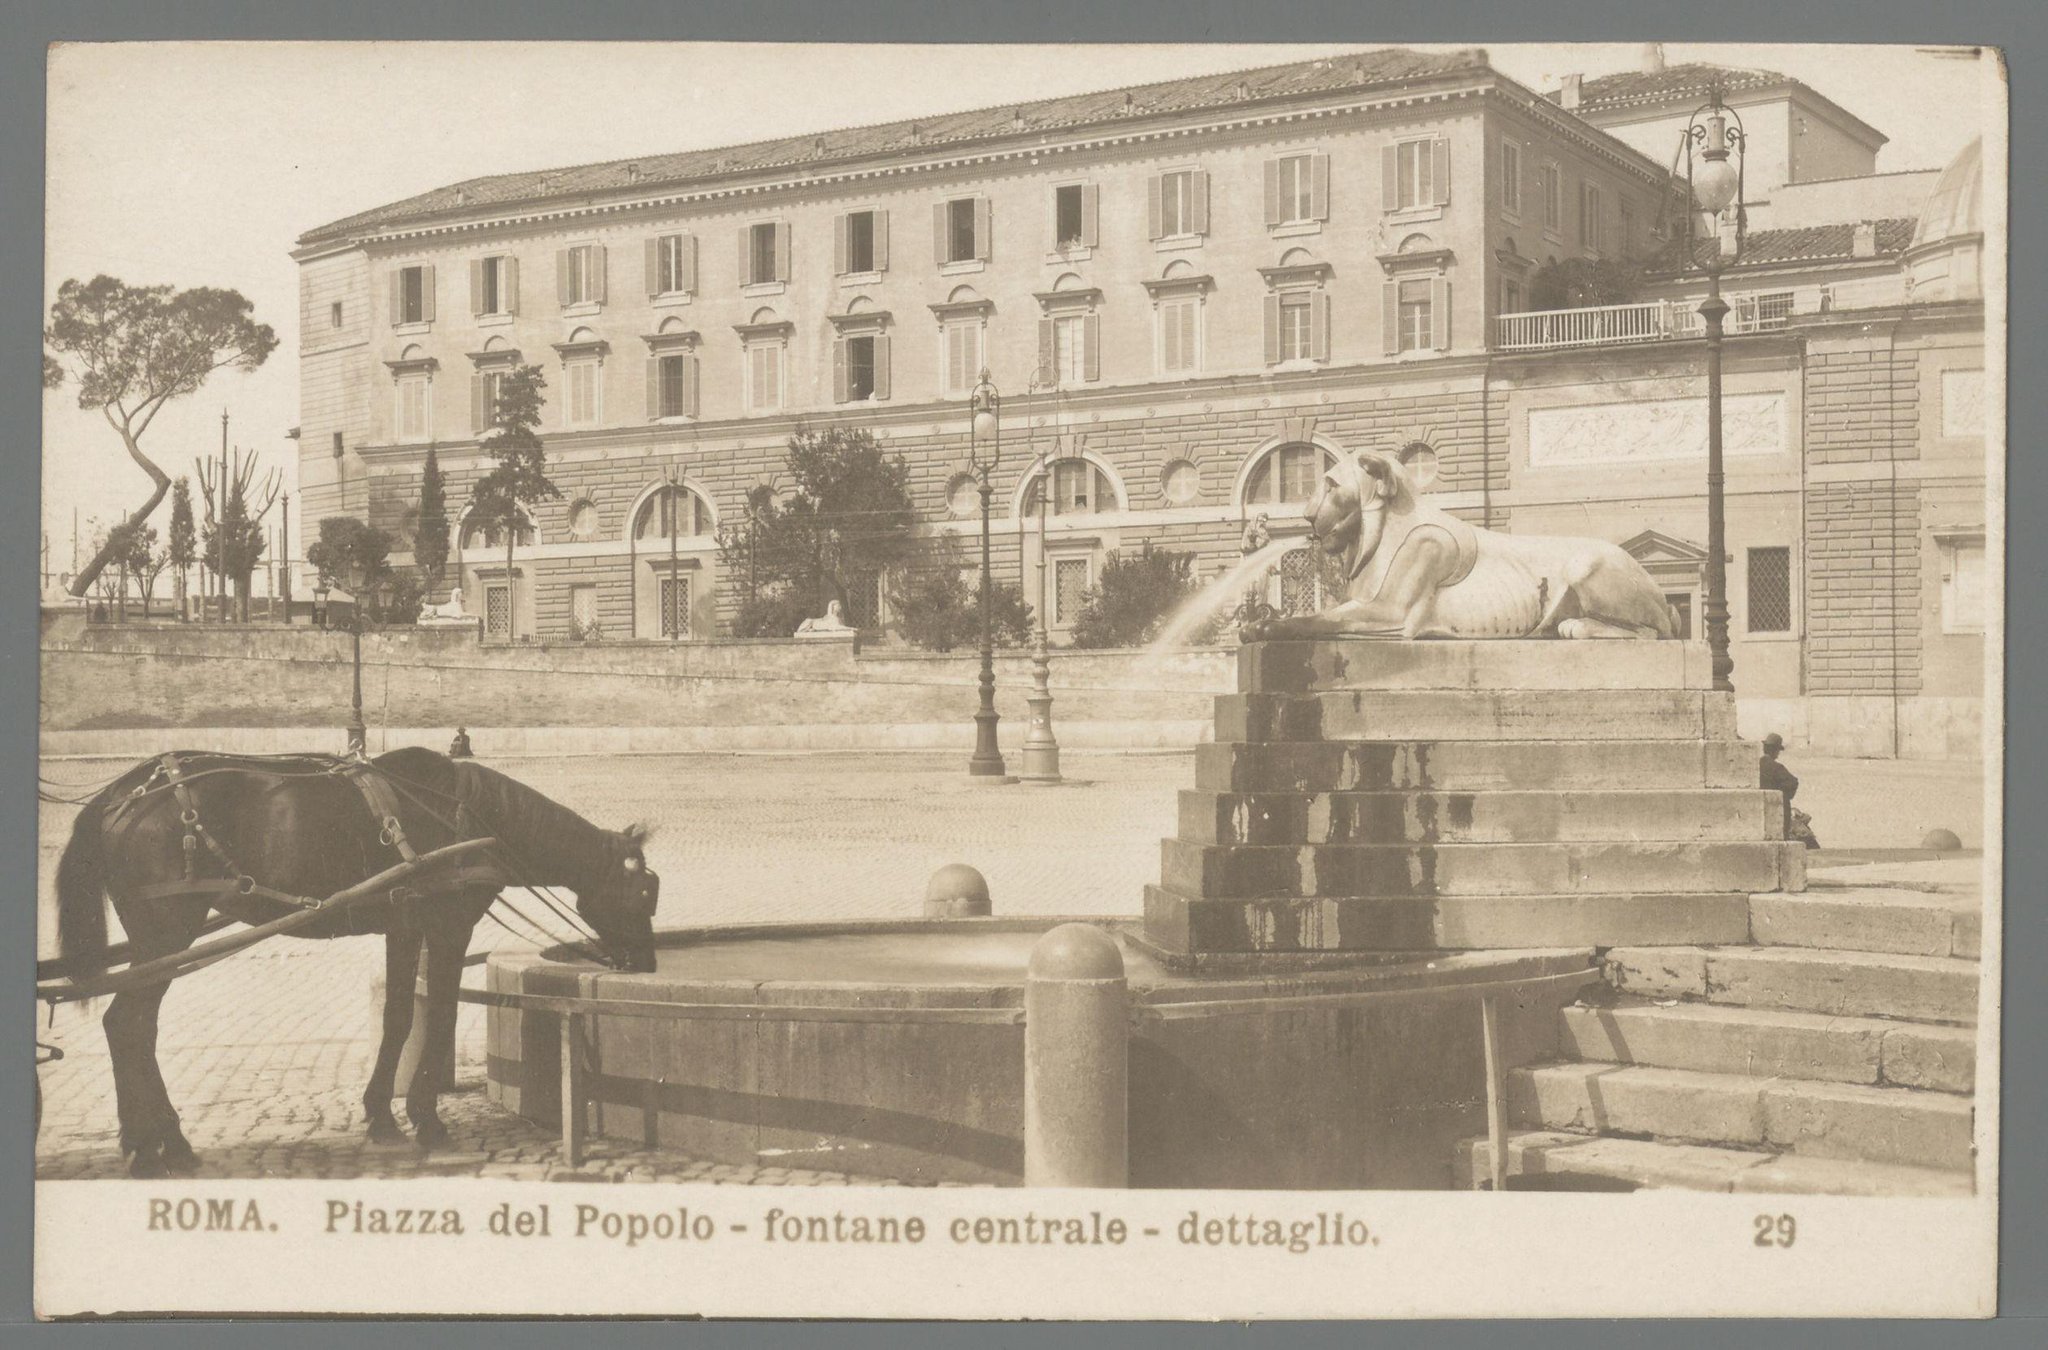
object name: photograph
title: Roma. Piazza del Popolo. Fontane centrale, dettaglio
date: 1900-1906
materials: photographic support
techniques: photography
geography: rome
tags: horse, square, place, circus, etc. (+ city(-scape) with figures, staffage), ornamental fountain (+ city(-scape) with figures, staffage)